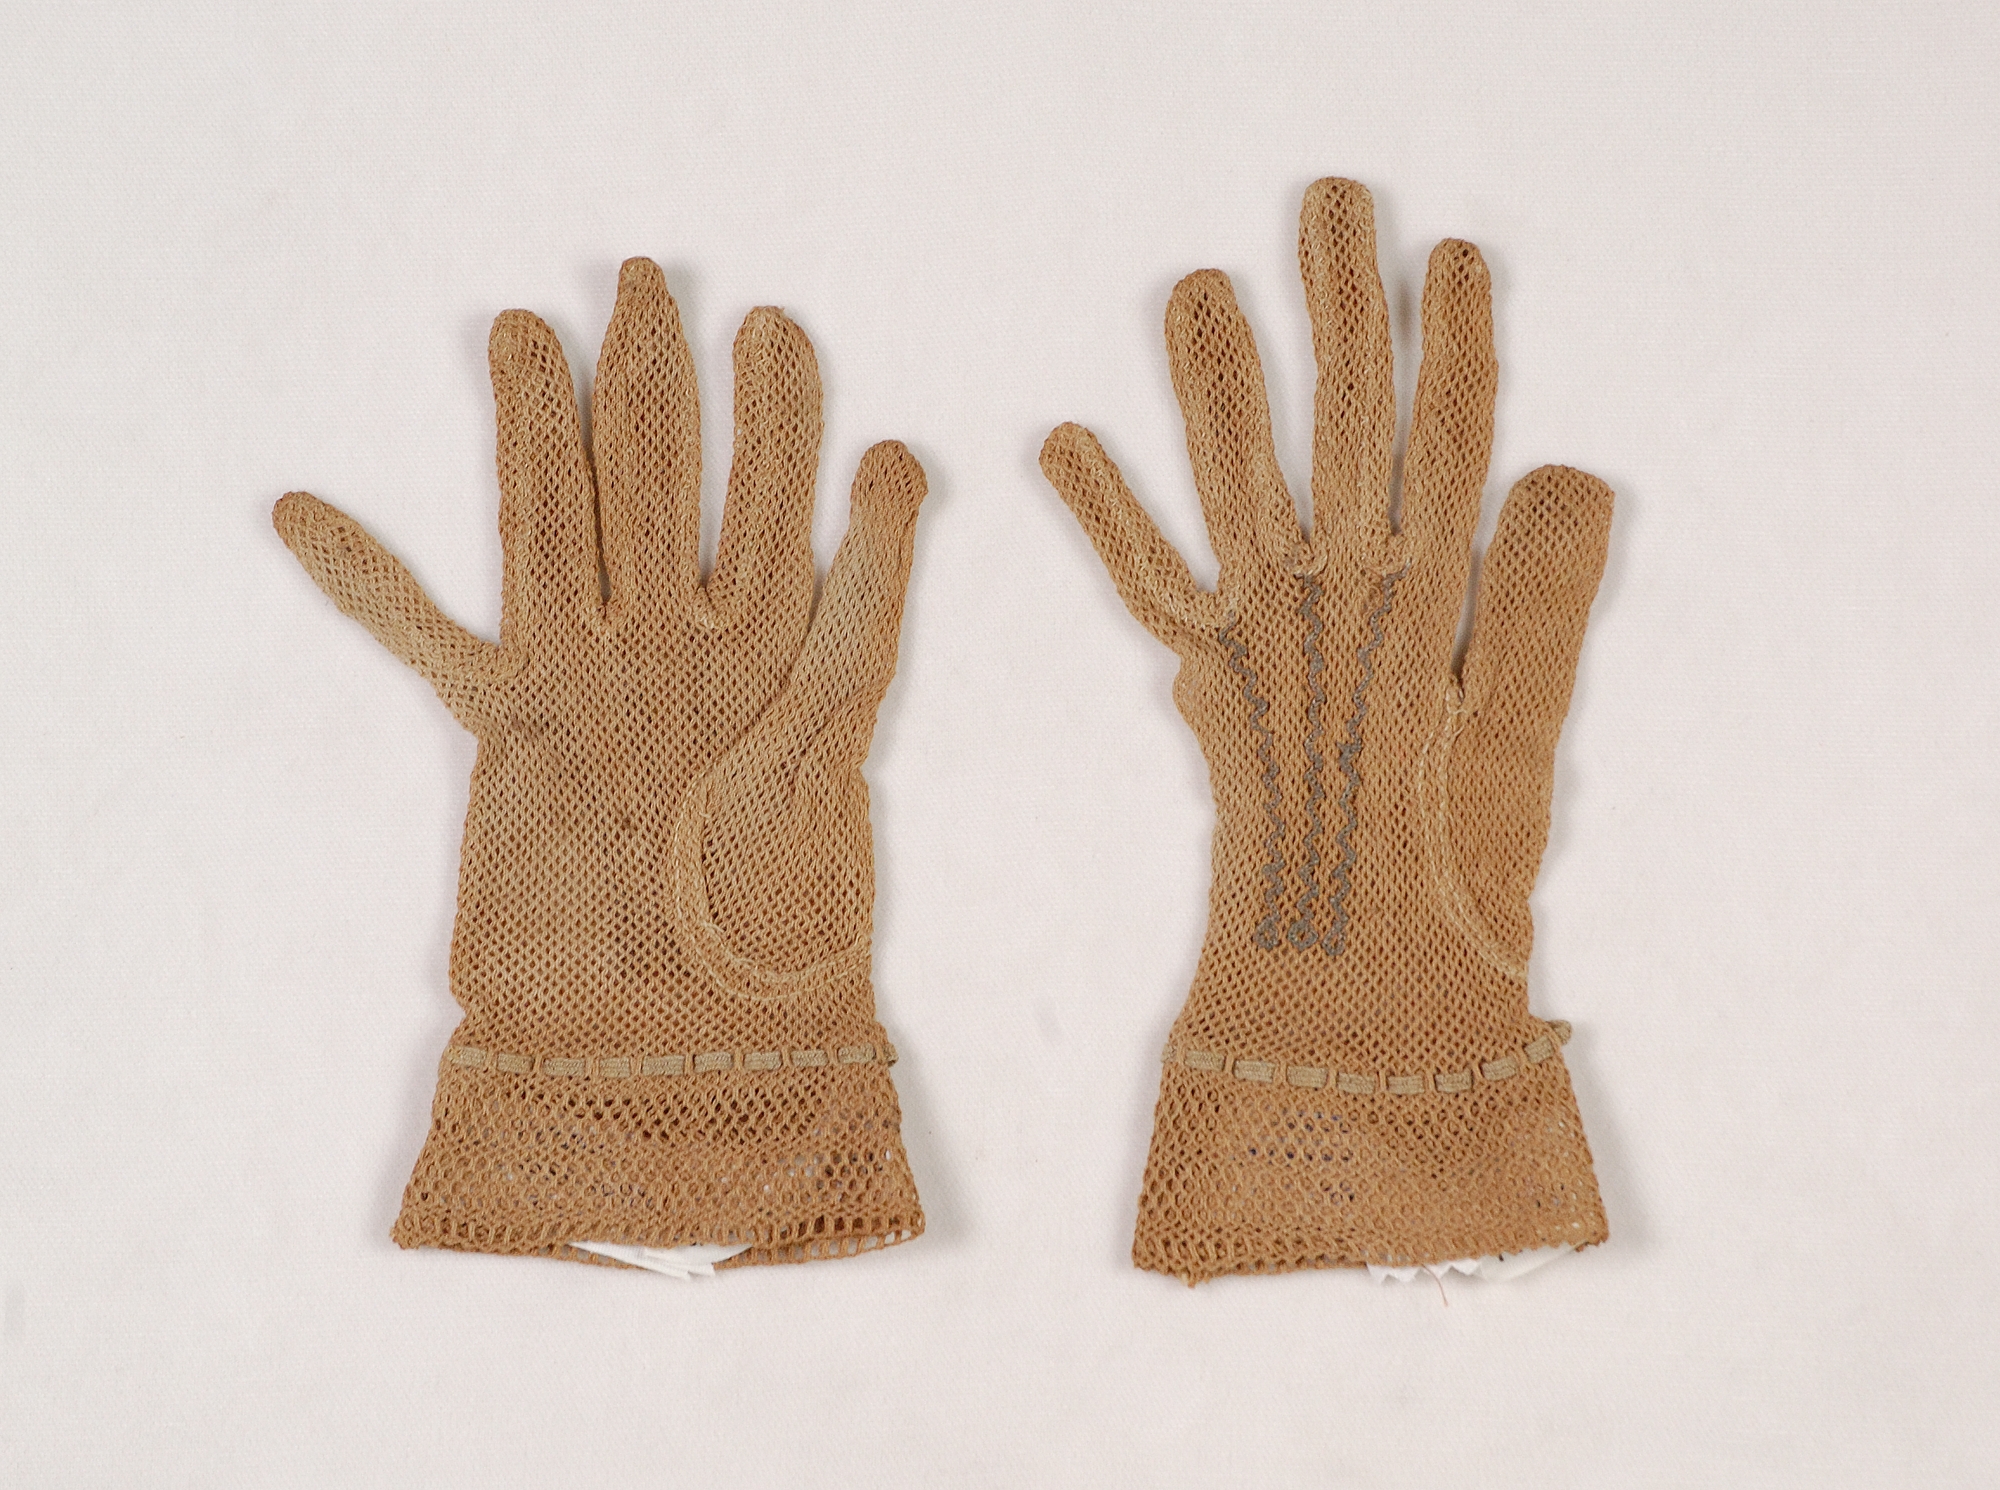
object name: glove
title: Gloves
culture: american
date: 1851-1875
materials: cotton